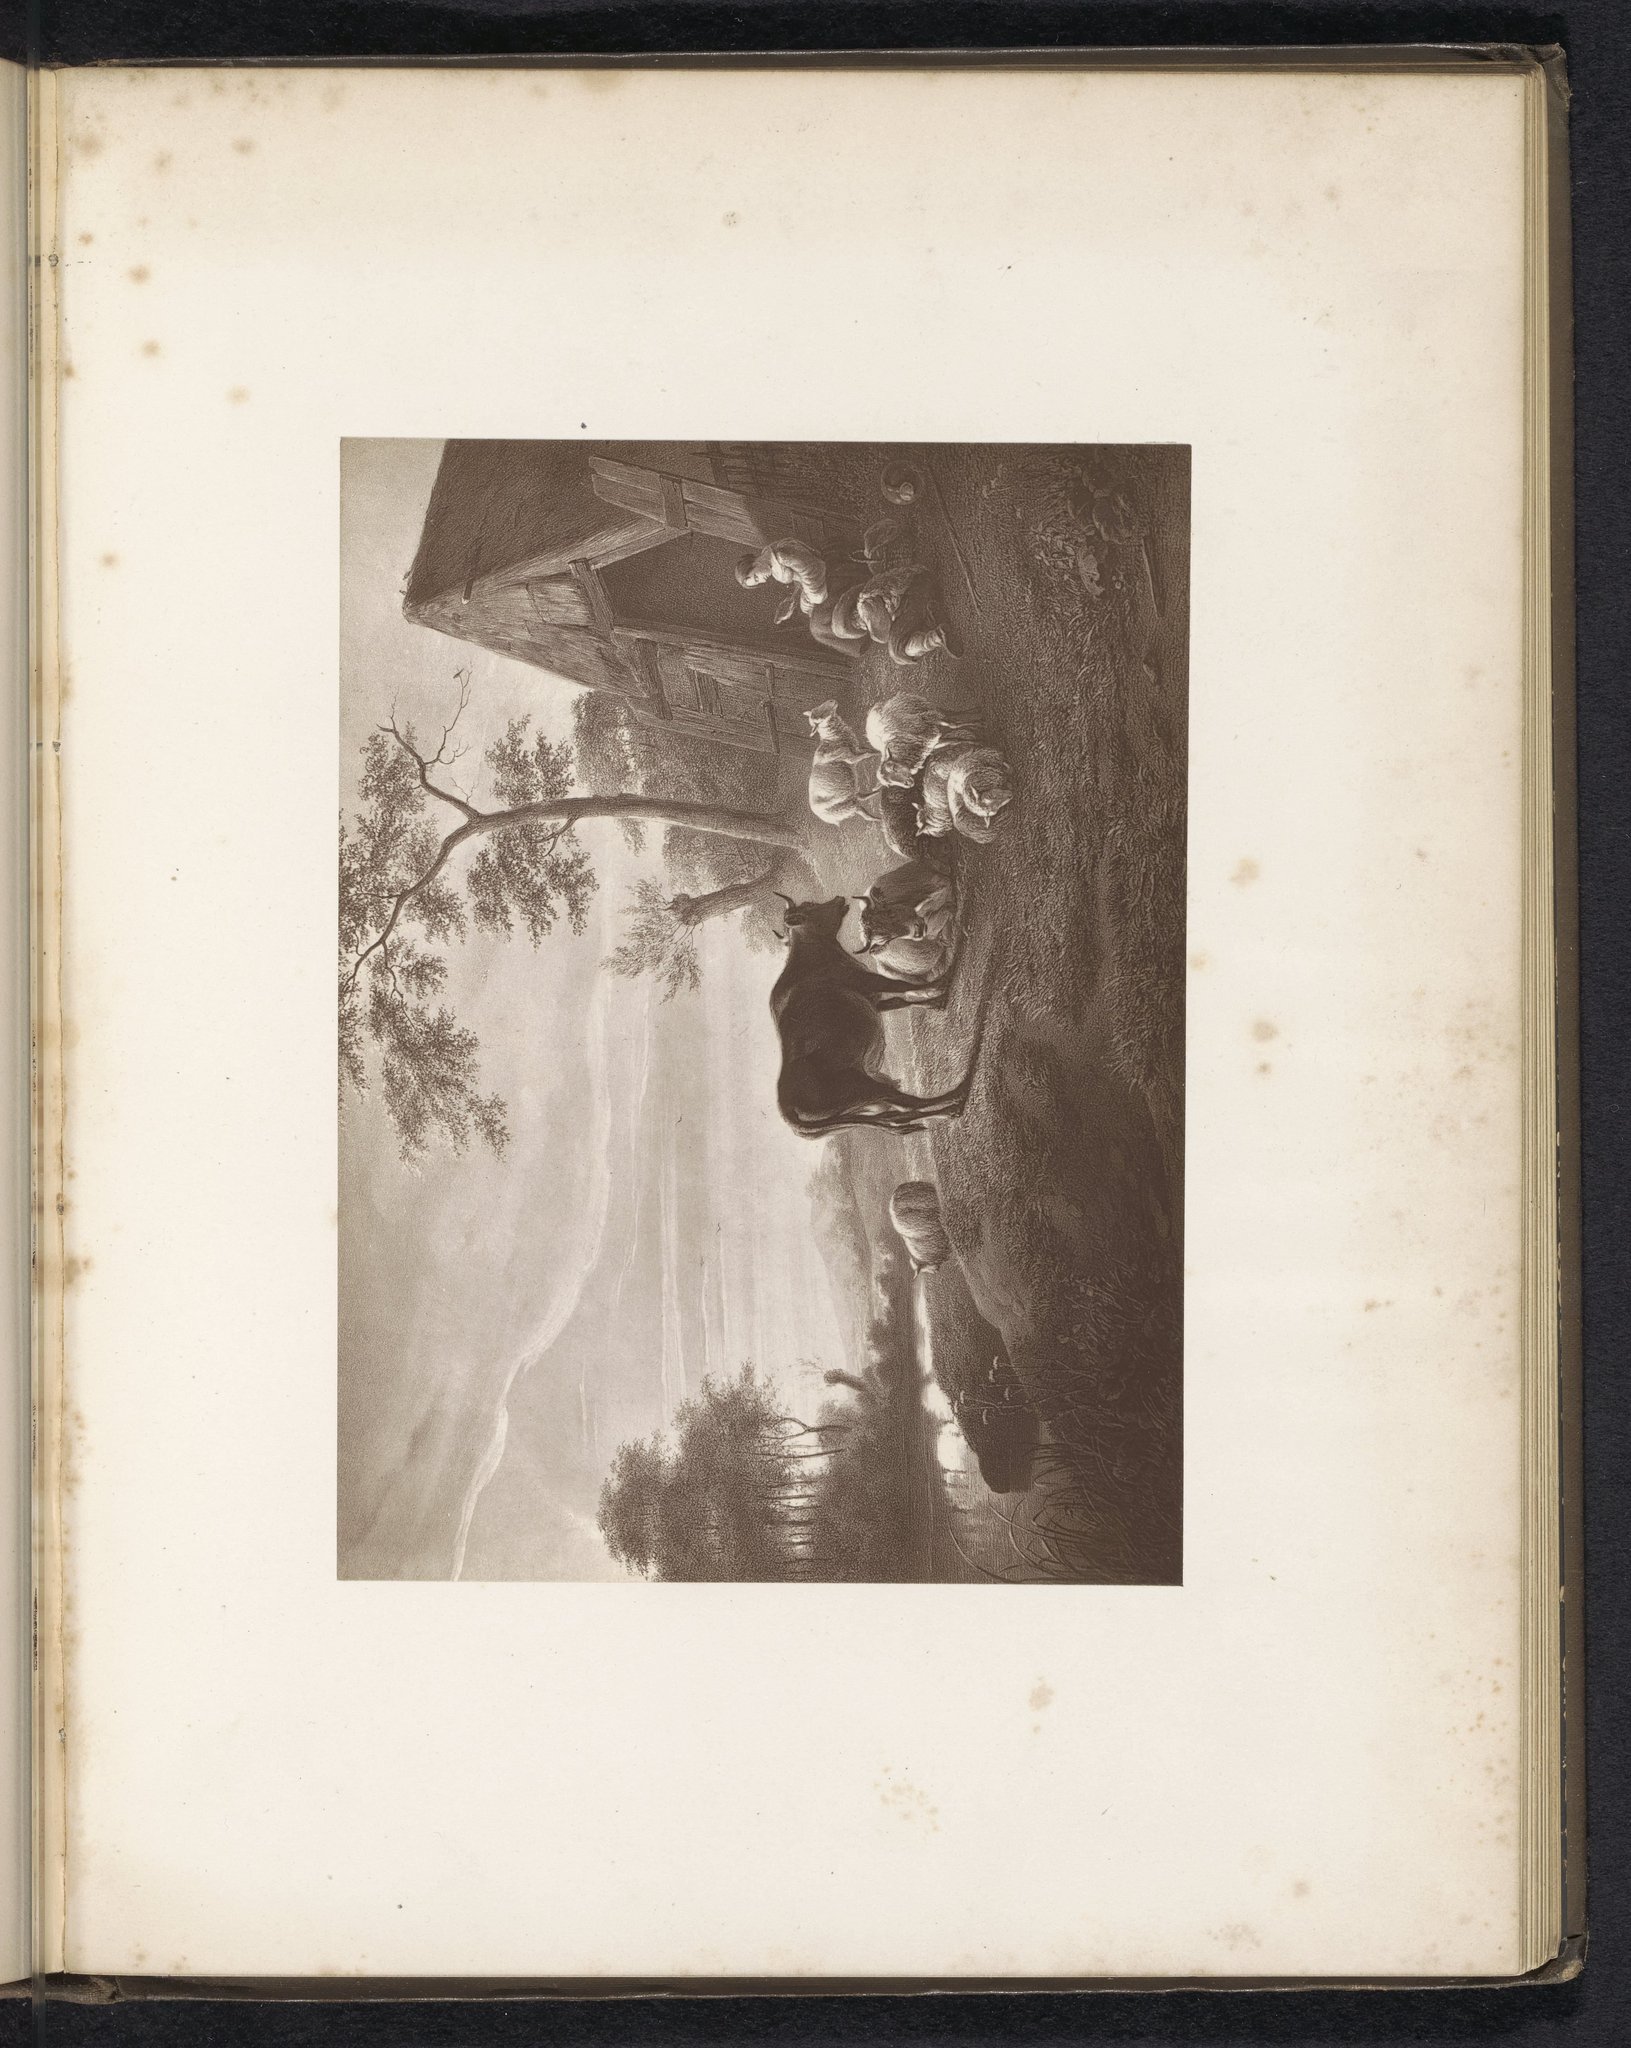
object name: reproduction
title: Fotoreproductie van een prent naar een schilderij, voorstellende een kudde met een herder in een weide bij schemering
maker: Anonymous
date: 1859-1869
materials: photographic support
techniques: albumen print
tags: cattle, meadow, pasture, sunset